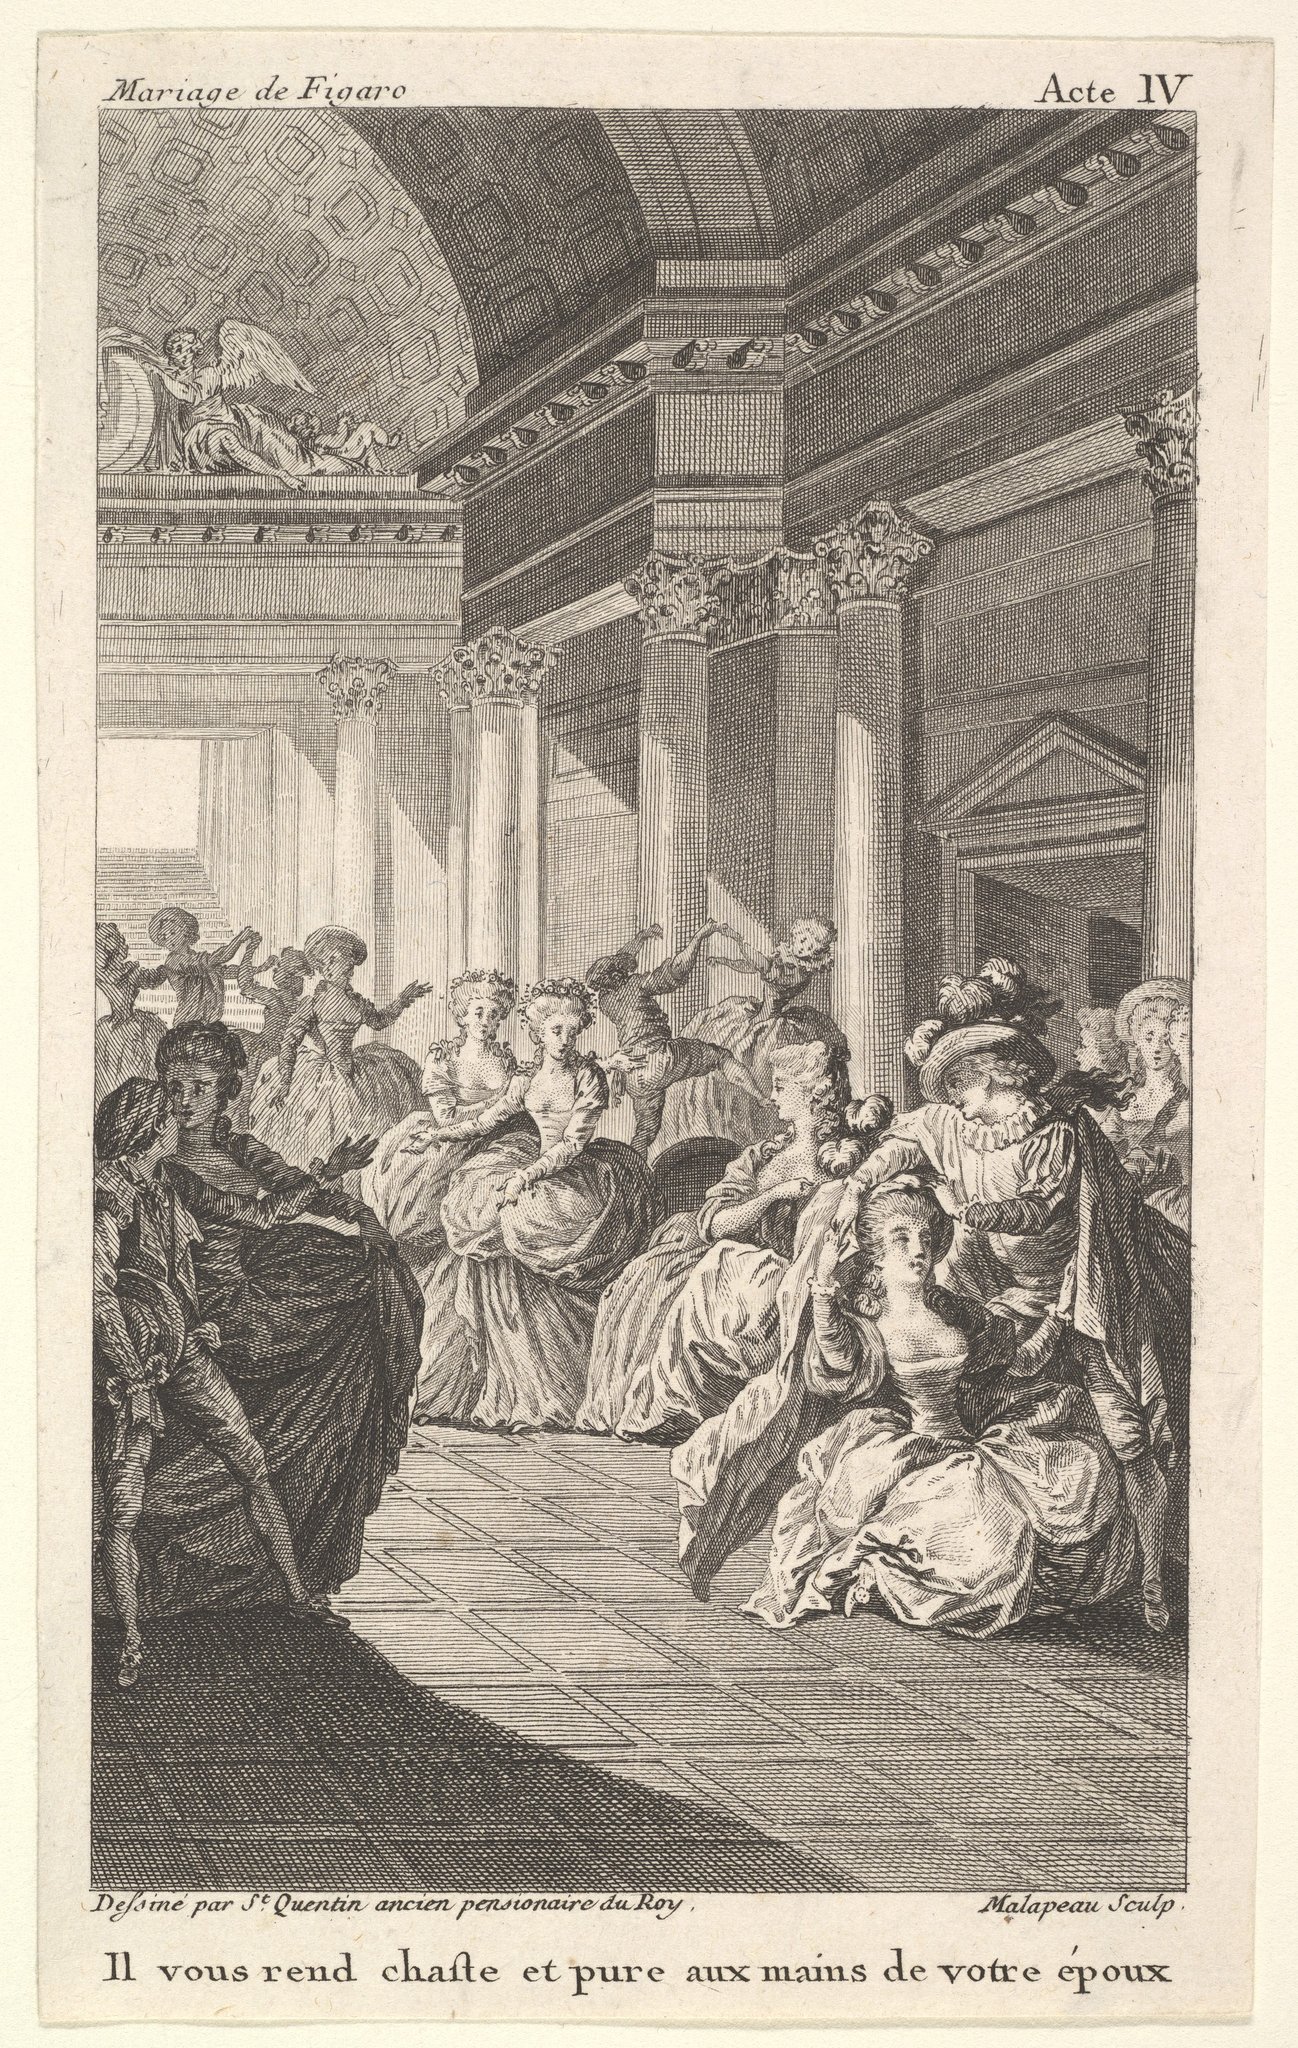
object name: print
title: Dancing couples surround four standing women in a barrel-vaulted hall, from a series of five illustrations after Jacques Philippe Joseph de Saint-Quentin for 'The mad day, or the marriage of Figaro' (La Folle journée, ou le mariage de Figaro) by Pierre Augustin Caron de Beaumarchais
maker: jacques philippe joseph de saint quentin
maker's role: artist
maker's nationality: french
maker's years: 1738-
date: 1784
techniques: engraving, etching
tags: couples,men,women,dancing